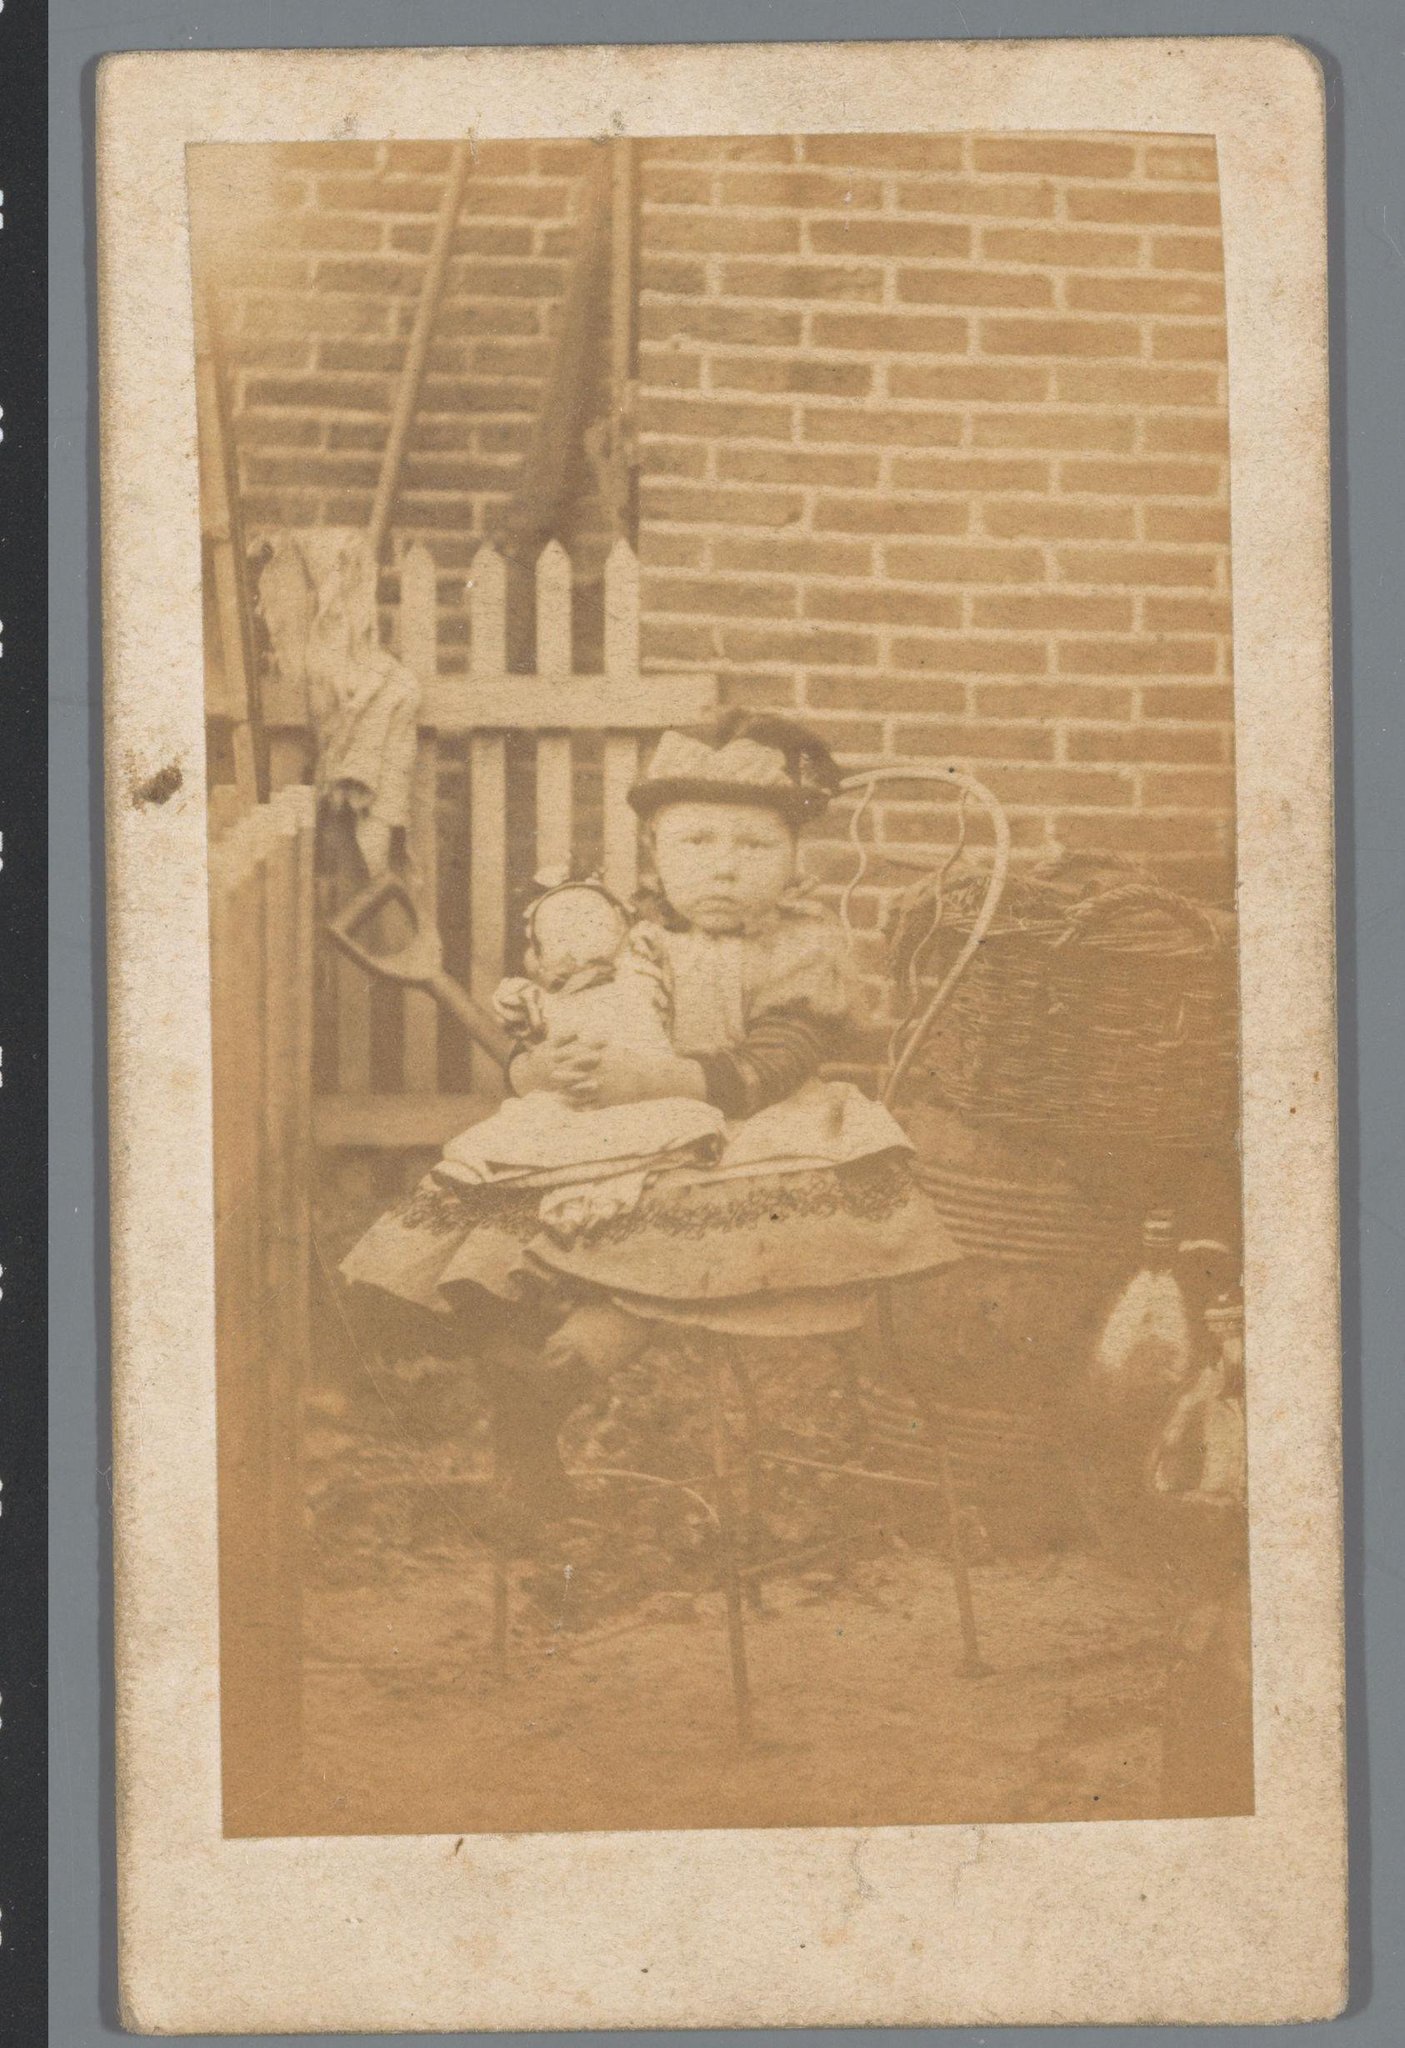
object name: photograph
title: Portret van een onbekend kind met een pop op een stoel buiten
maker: heinrich steinhauer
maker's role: fotograaf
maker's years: 1838-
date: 1863-1875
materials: cardboard, paper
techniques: albumen print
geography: nieuwediep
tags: girl (child between toddler and youth), anonymous historical person portrayed, (playing with) dolls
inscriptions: inscription: ‘H. Steinhauer/ Photograph/ Hoofdgracht/ Nieuwediep.’